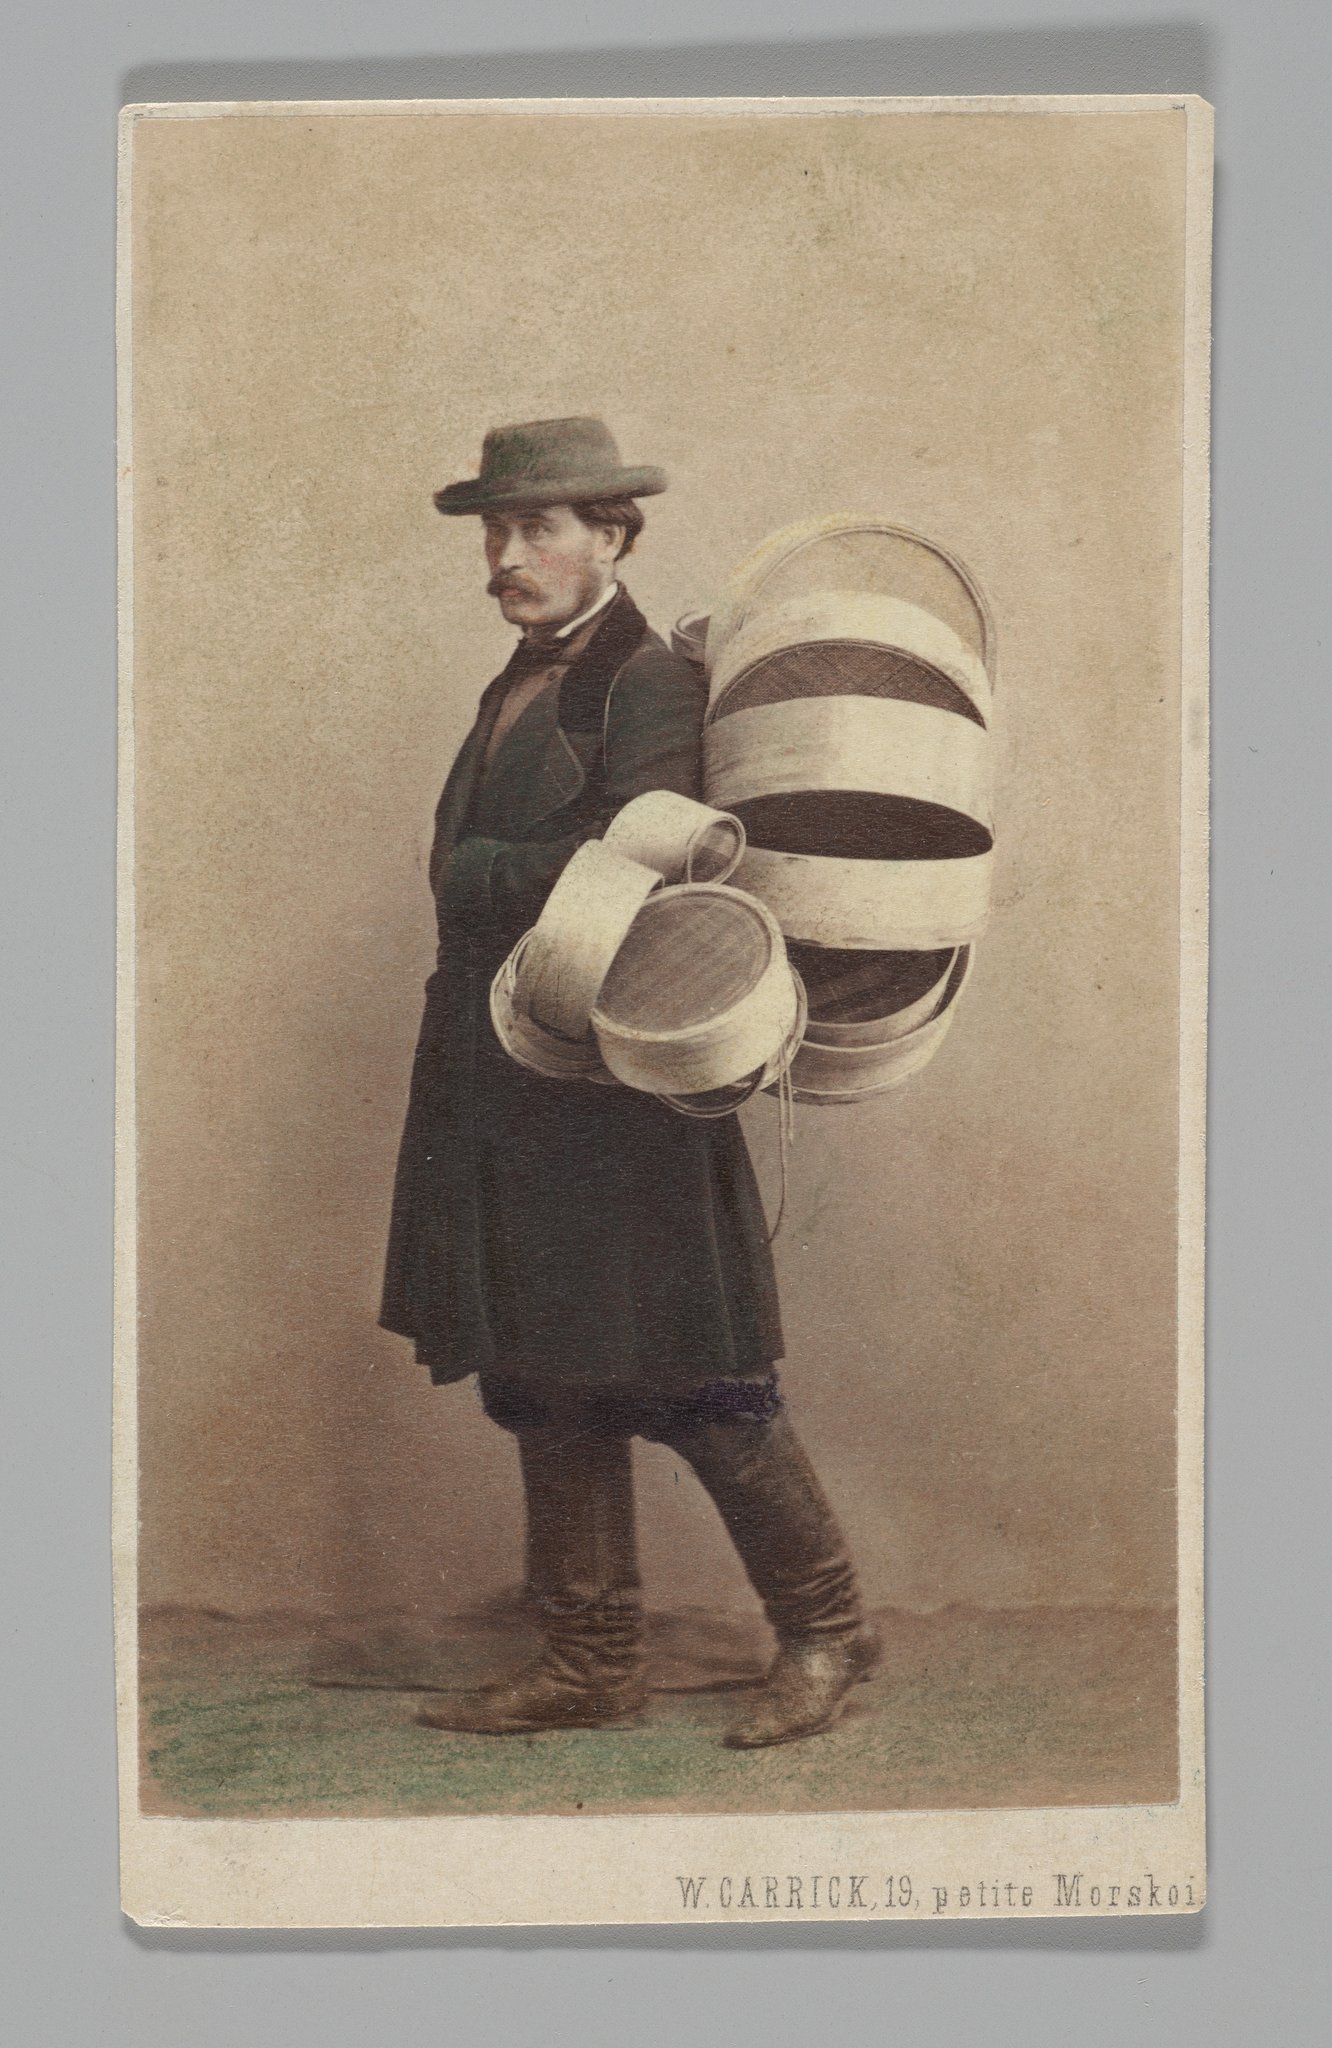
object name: carte de visite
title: [Studio Portrait: Man in Coat Carrying Baskets, St. Petersburg]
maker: william carrick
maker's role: artist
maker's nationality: british, scottish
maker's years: 1827-1878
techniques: albumen silver print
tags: men,portraits,baskets